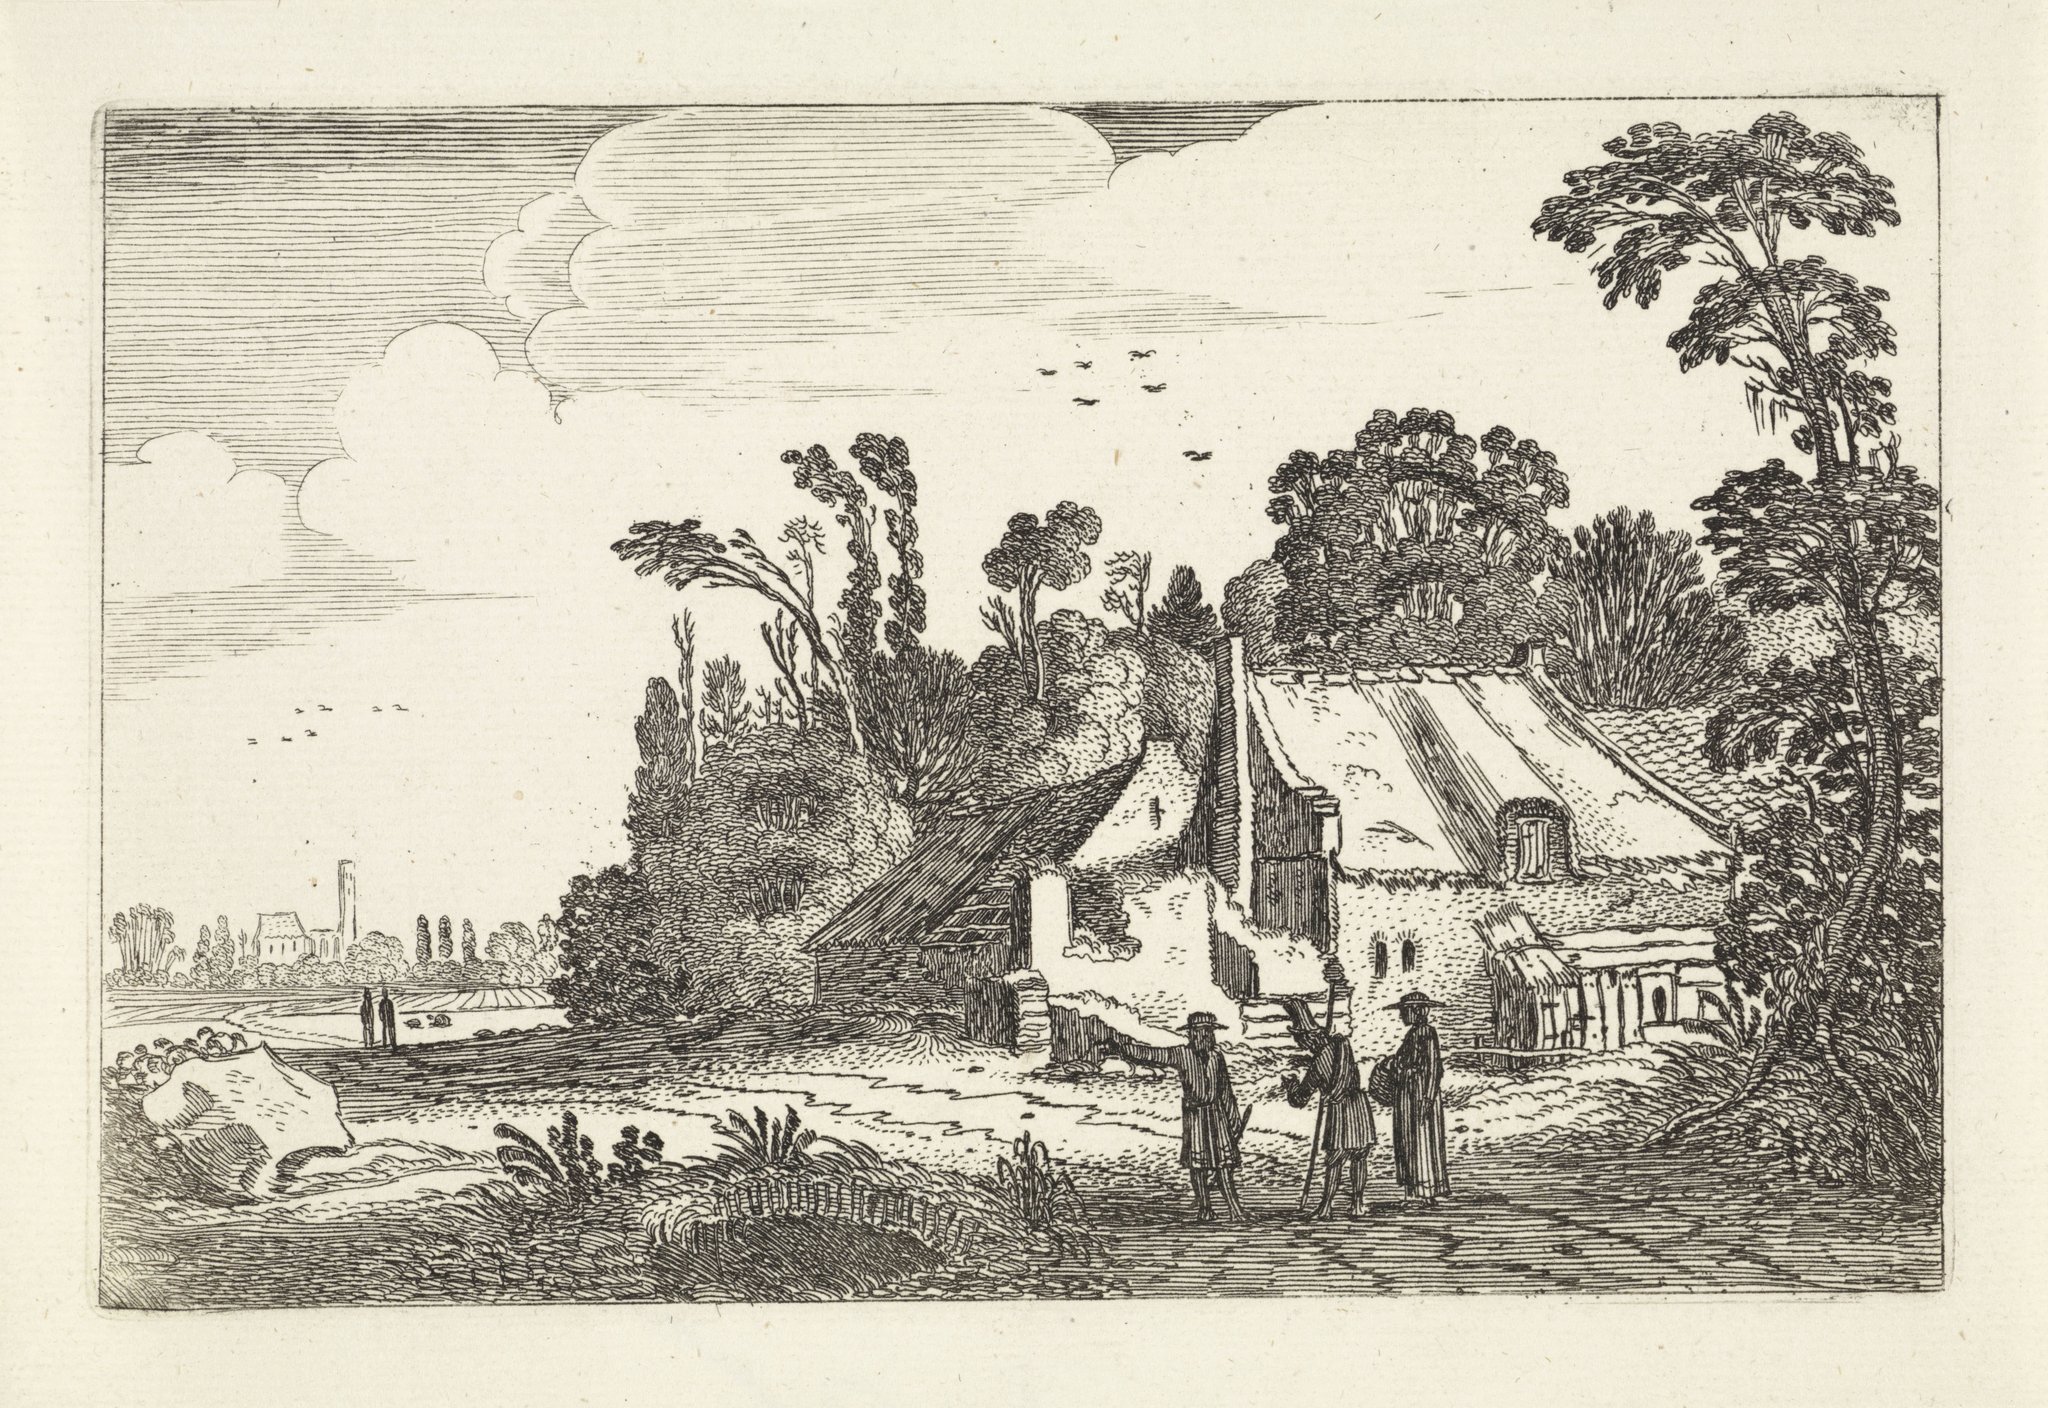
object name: print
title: Figuren op een landweg bij een boerderij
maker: jan van de velde (ii)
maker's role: draughtsman, painter, print maker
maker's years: 1593-1641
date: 1616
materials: paper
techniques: etching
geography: northern netherlands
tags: 'en route', traveller under way, farm or solitary house in landscape, asking the way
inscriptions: collector's mark: Lugt 2228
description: Figuren op een landweg bij een boerderij. Een man maakt een wijzend gebaar. Oorspronkelijk tweede prent van deel vier van een serie van in totaal zestig prenten met landschappen, verdeeld over vijf delen van elk twaalf prenten.